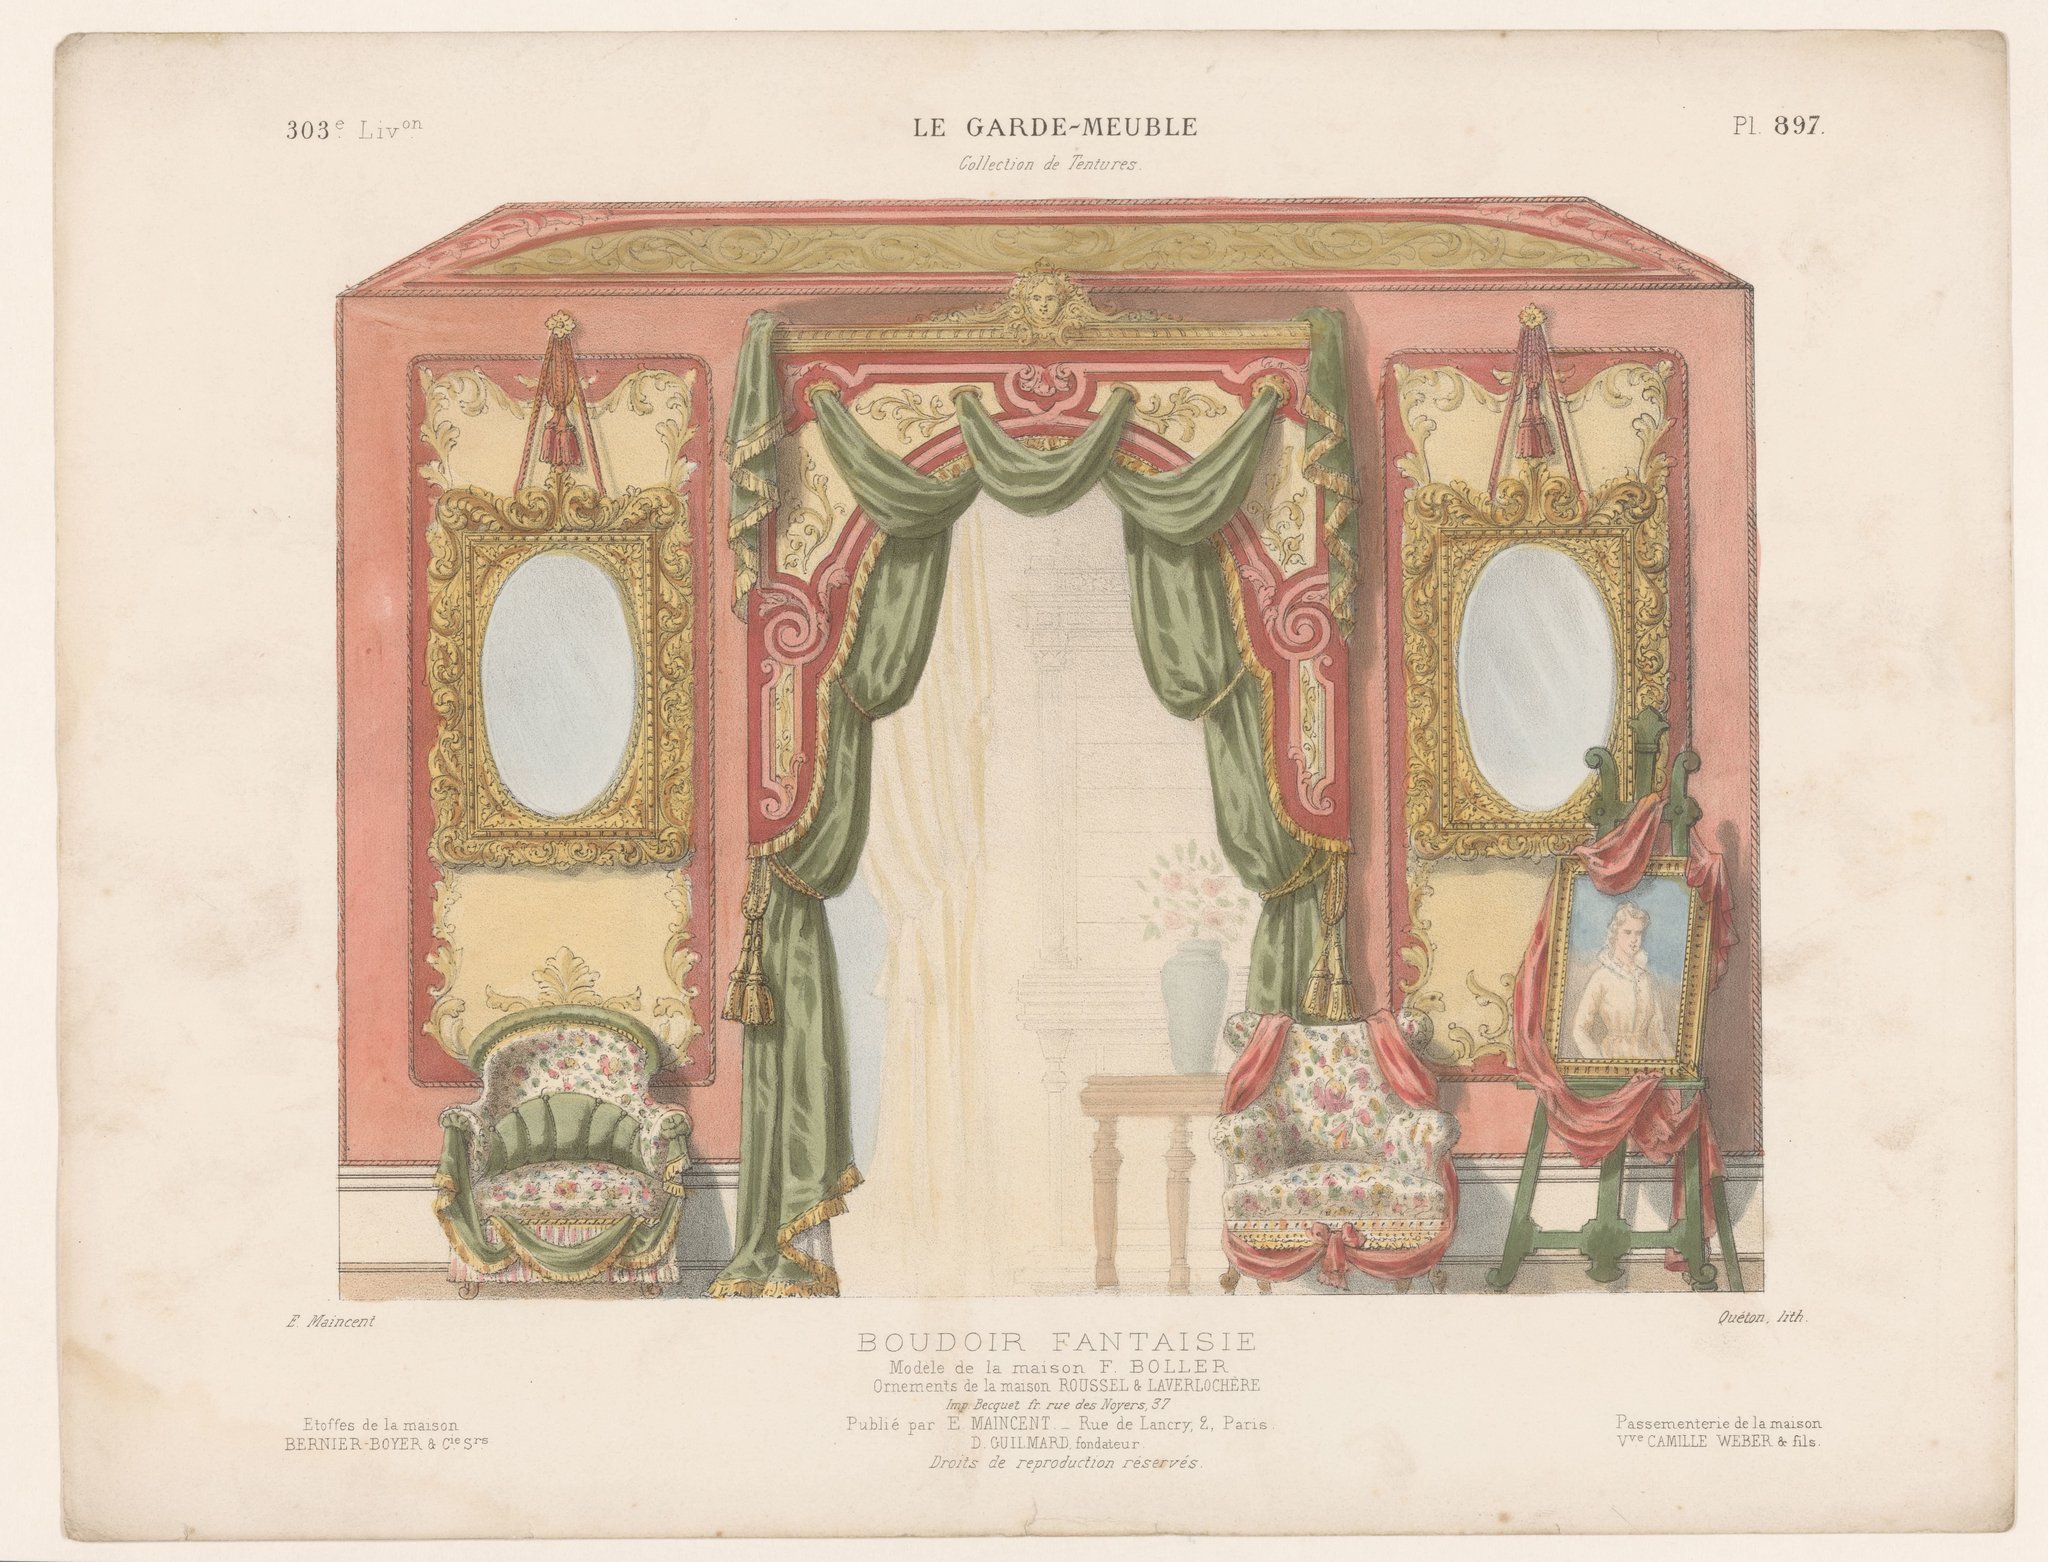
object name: print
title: Boudoir Fantaisie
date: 1885-1895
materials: paper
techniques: hand coloring, lithograph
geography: paris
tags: decorations (interior of the house), boudoir, hangings and drapery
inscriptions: : ‘Droits de reproduction réservés.’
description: Boudoir met fauteuils, spiegels en gedrapeerde gordijnen in fantasiestijl. Prent uit 303e Livraison.